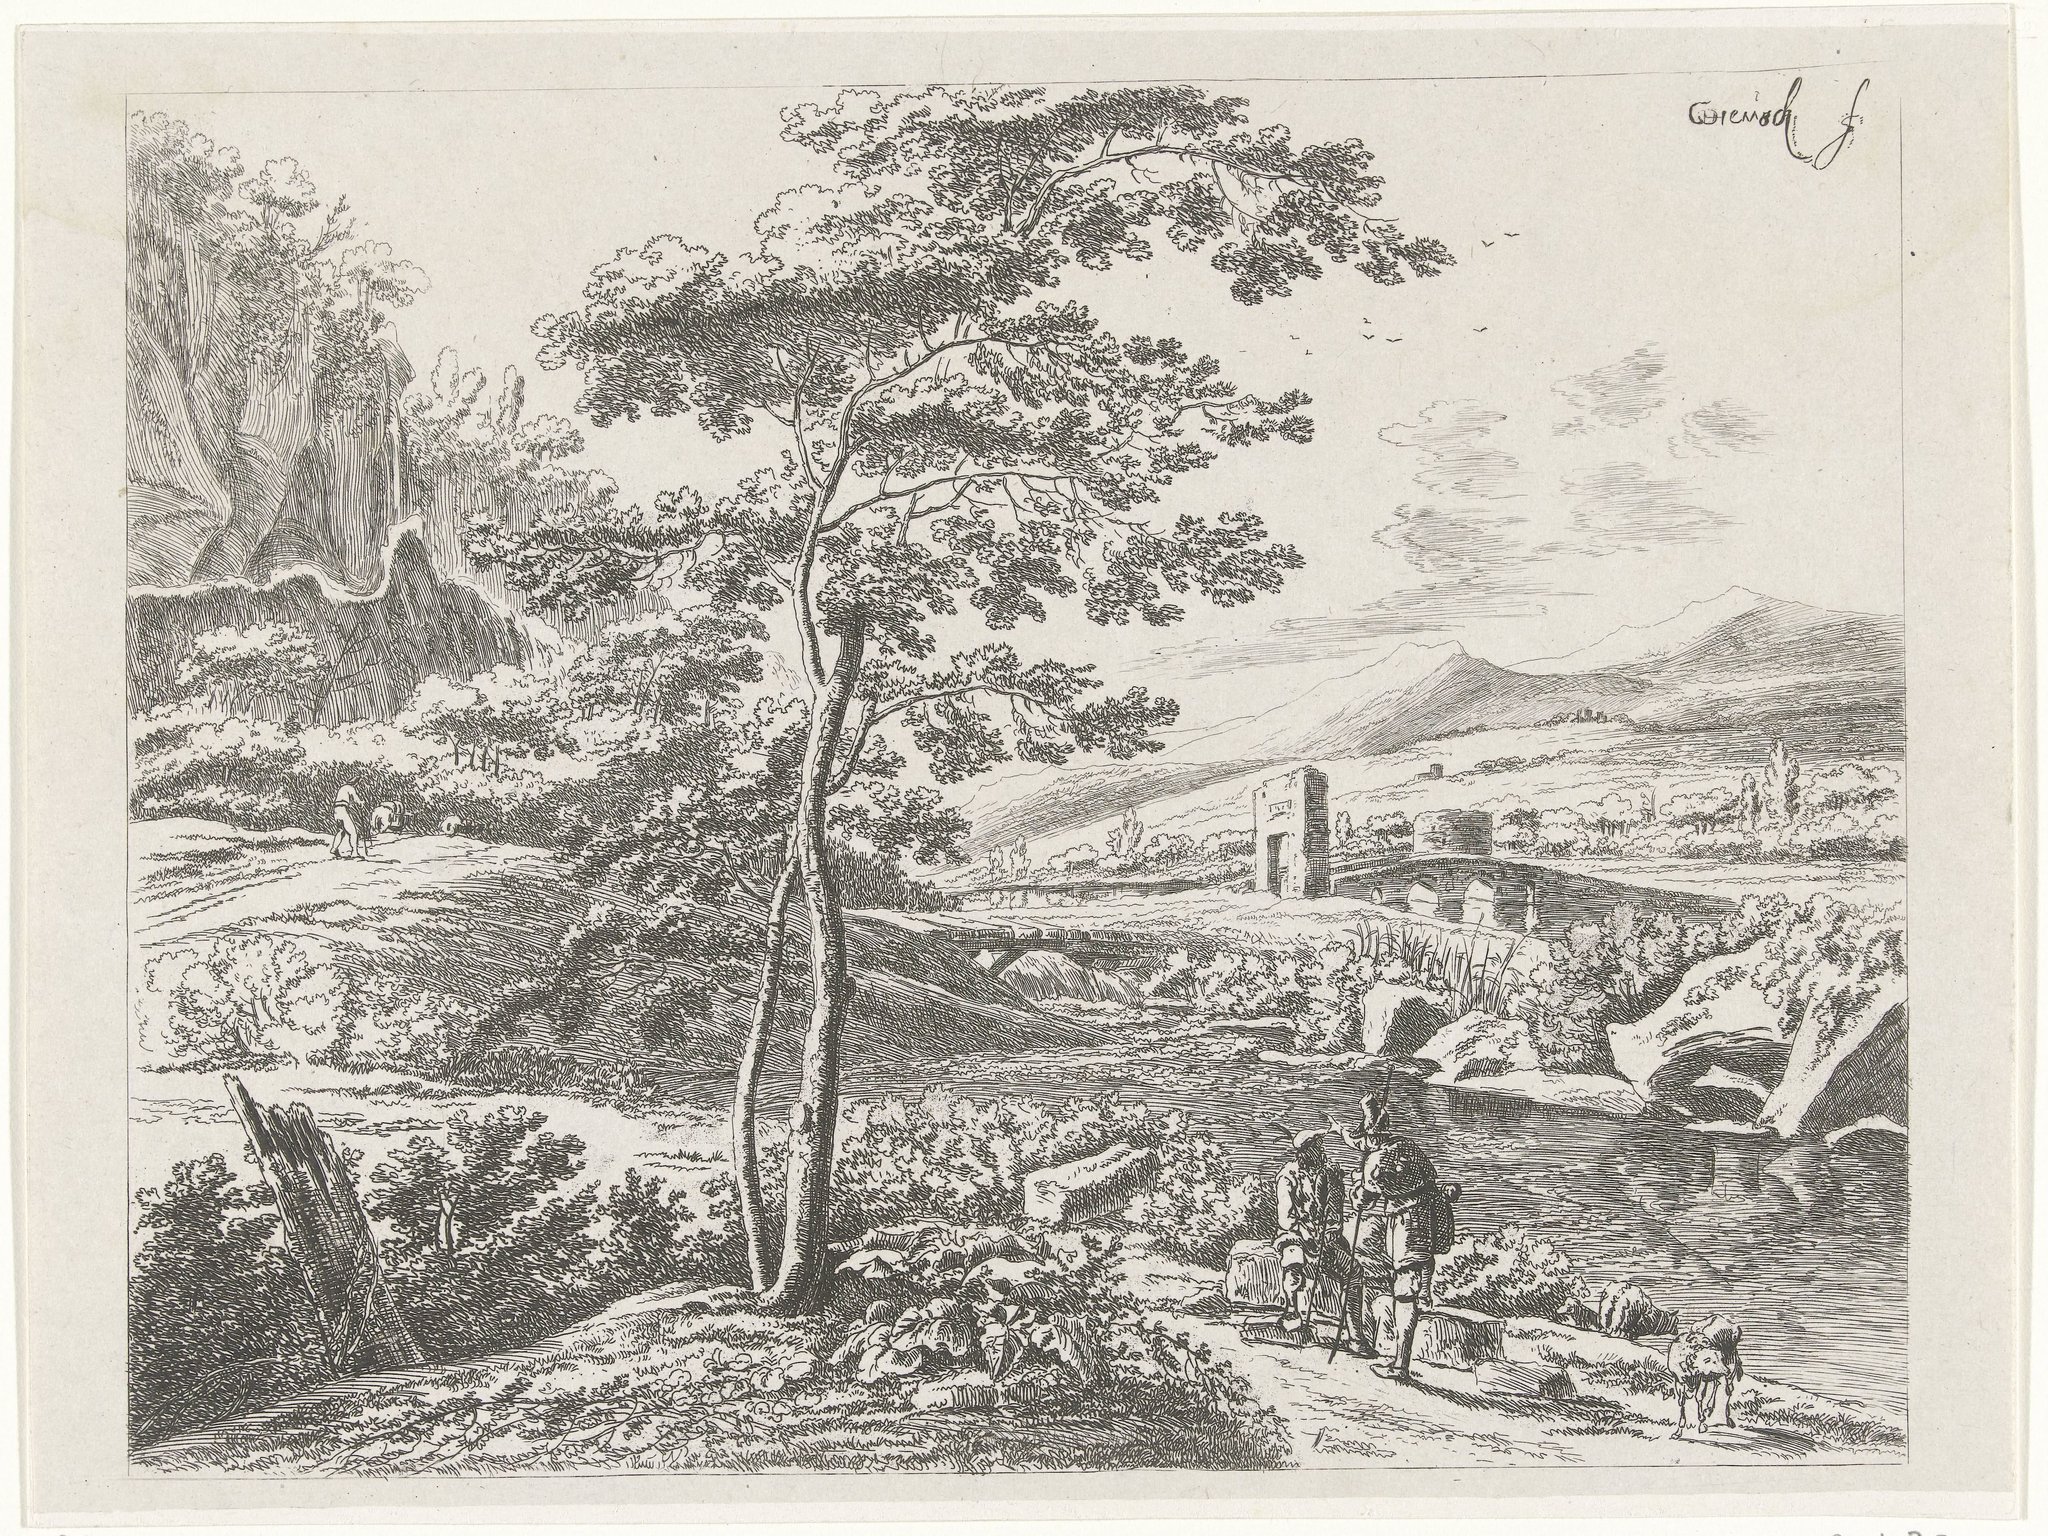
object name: print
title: Landschap met een pelgrim en een herder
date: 1828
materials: paper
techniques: etching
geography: utrecht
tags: herding, herdsman, herdswoman, shepherd, shepherdess, cowherd, etc., pilgrim(s), landscapes with waters, waterscapes, seascapes (in the temperate zone)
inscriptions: collector's mark: Lugt 2228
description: Een pelgrim met een staf in zijn hand en jakobsschelpen op zijn mantel bij een zittende herder met schapen. Op de achtergrond een figuur met twee pakezels op een heuvel. Kopie naar de derde prent uit de serie landschappen met figuren.